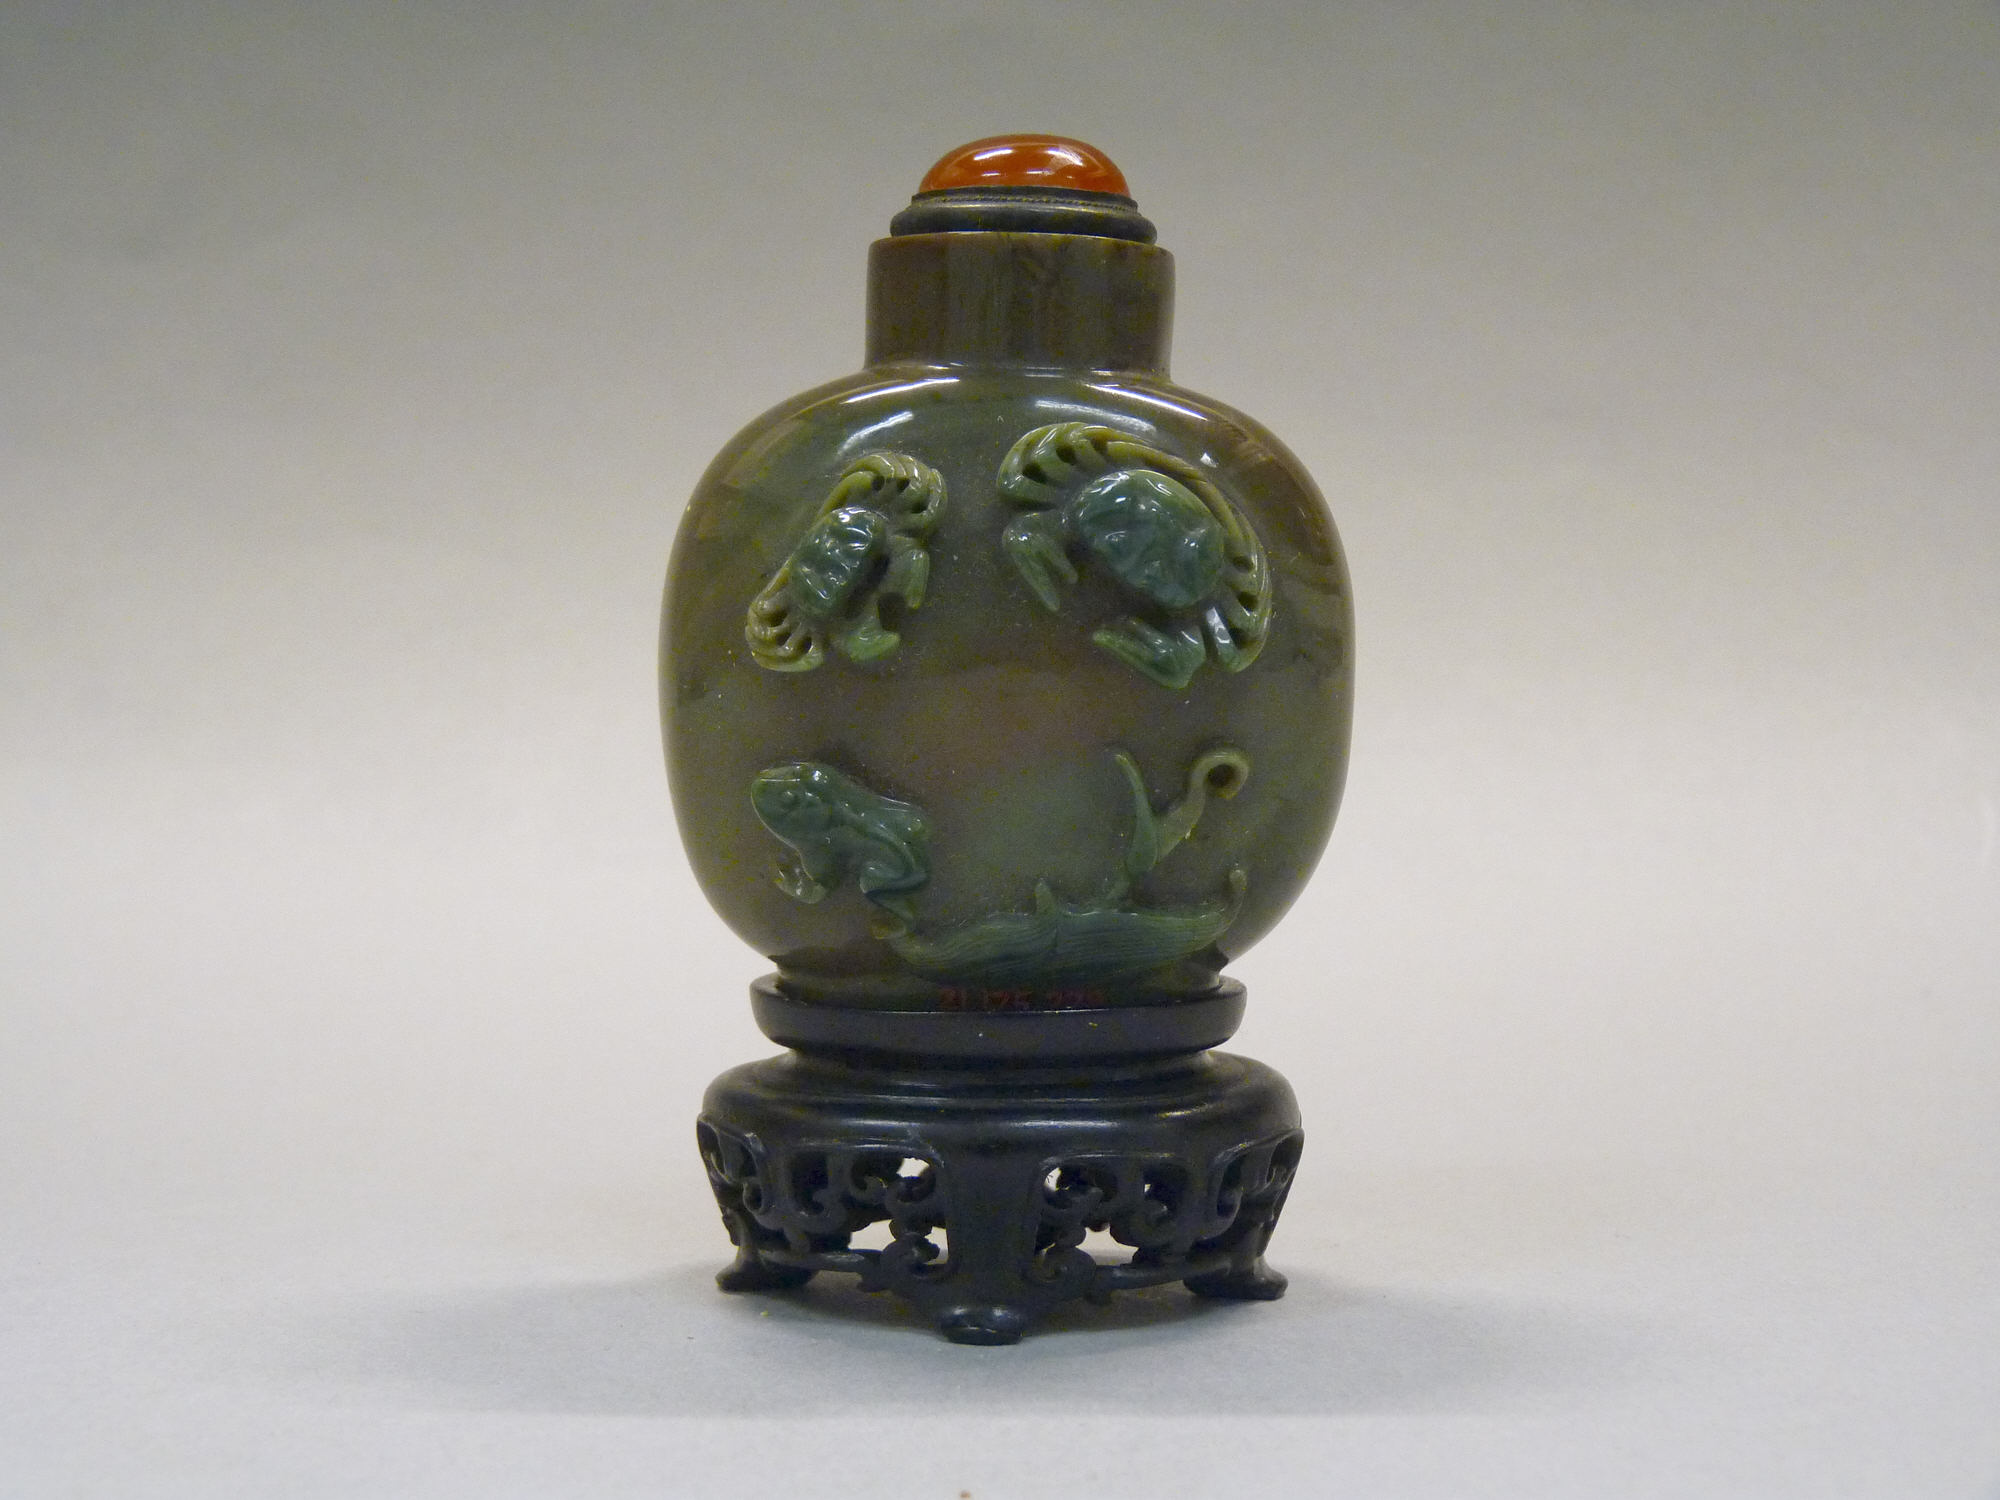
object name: snuff bottle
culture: chinese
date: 1736-1795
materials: stone, glass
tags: crabs,frogs